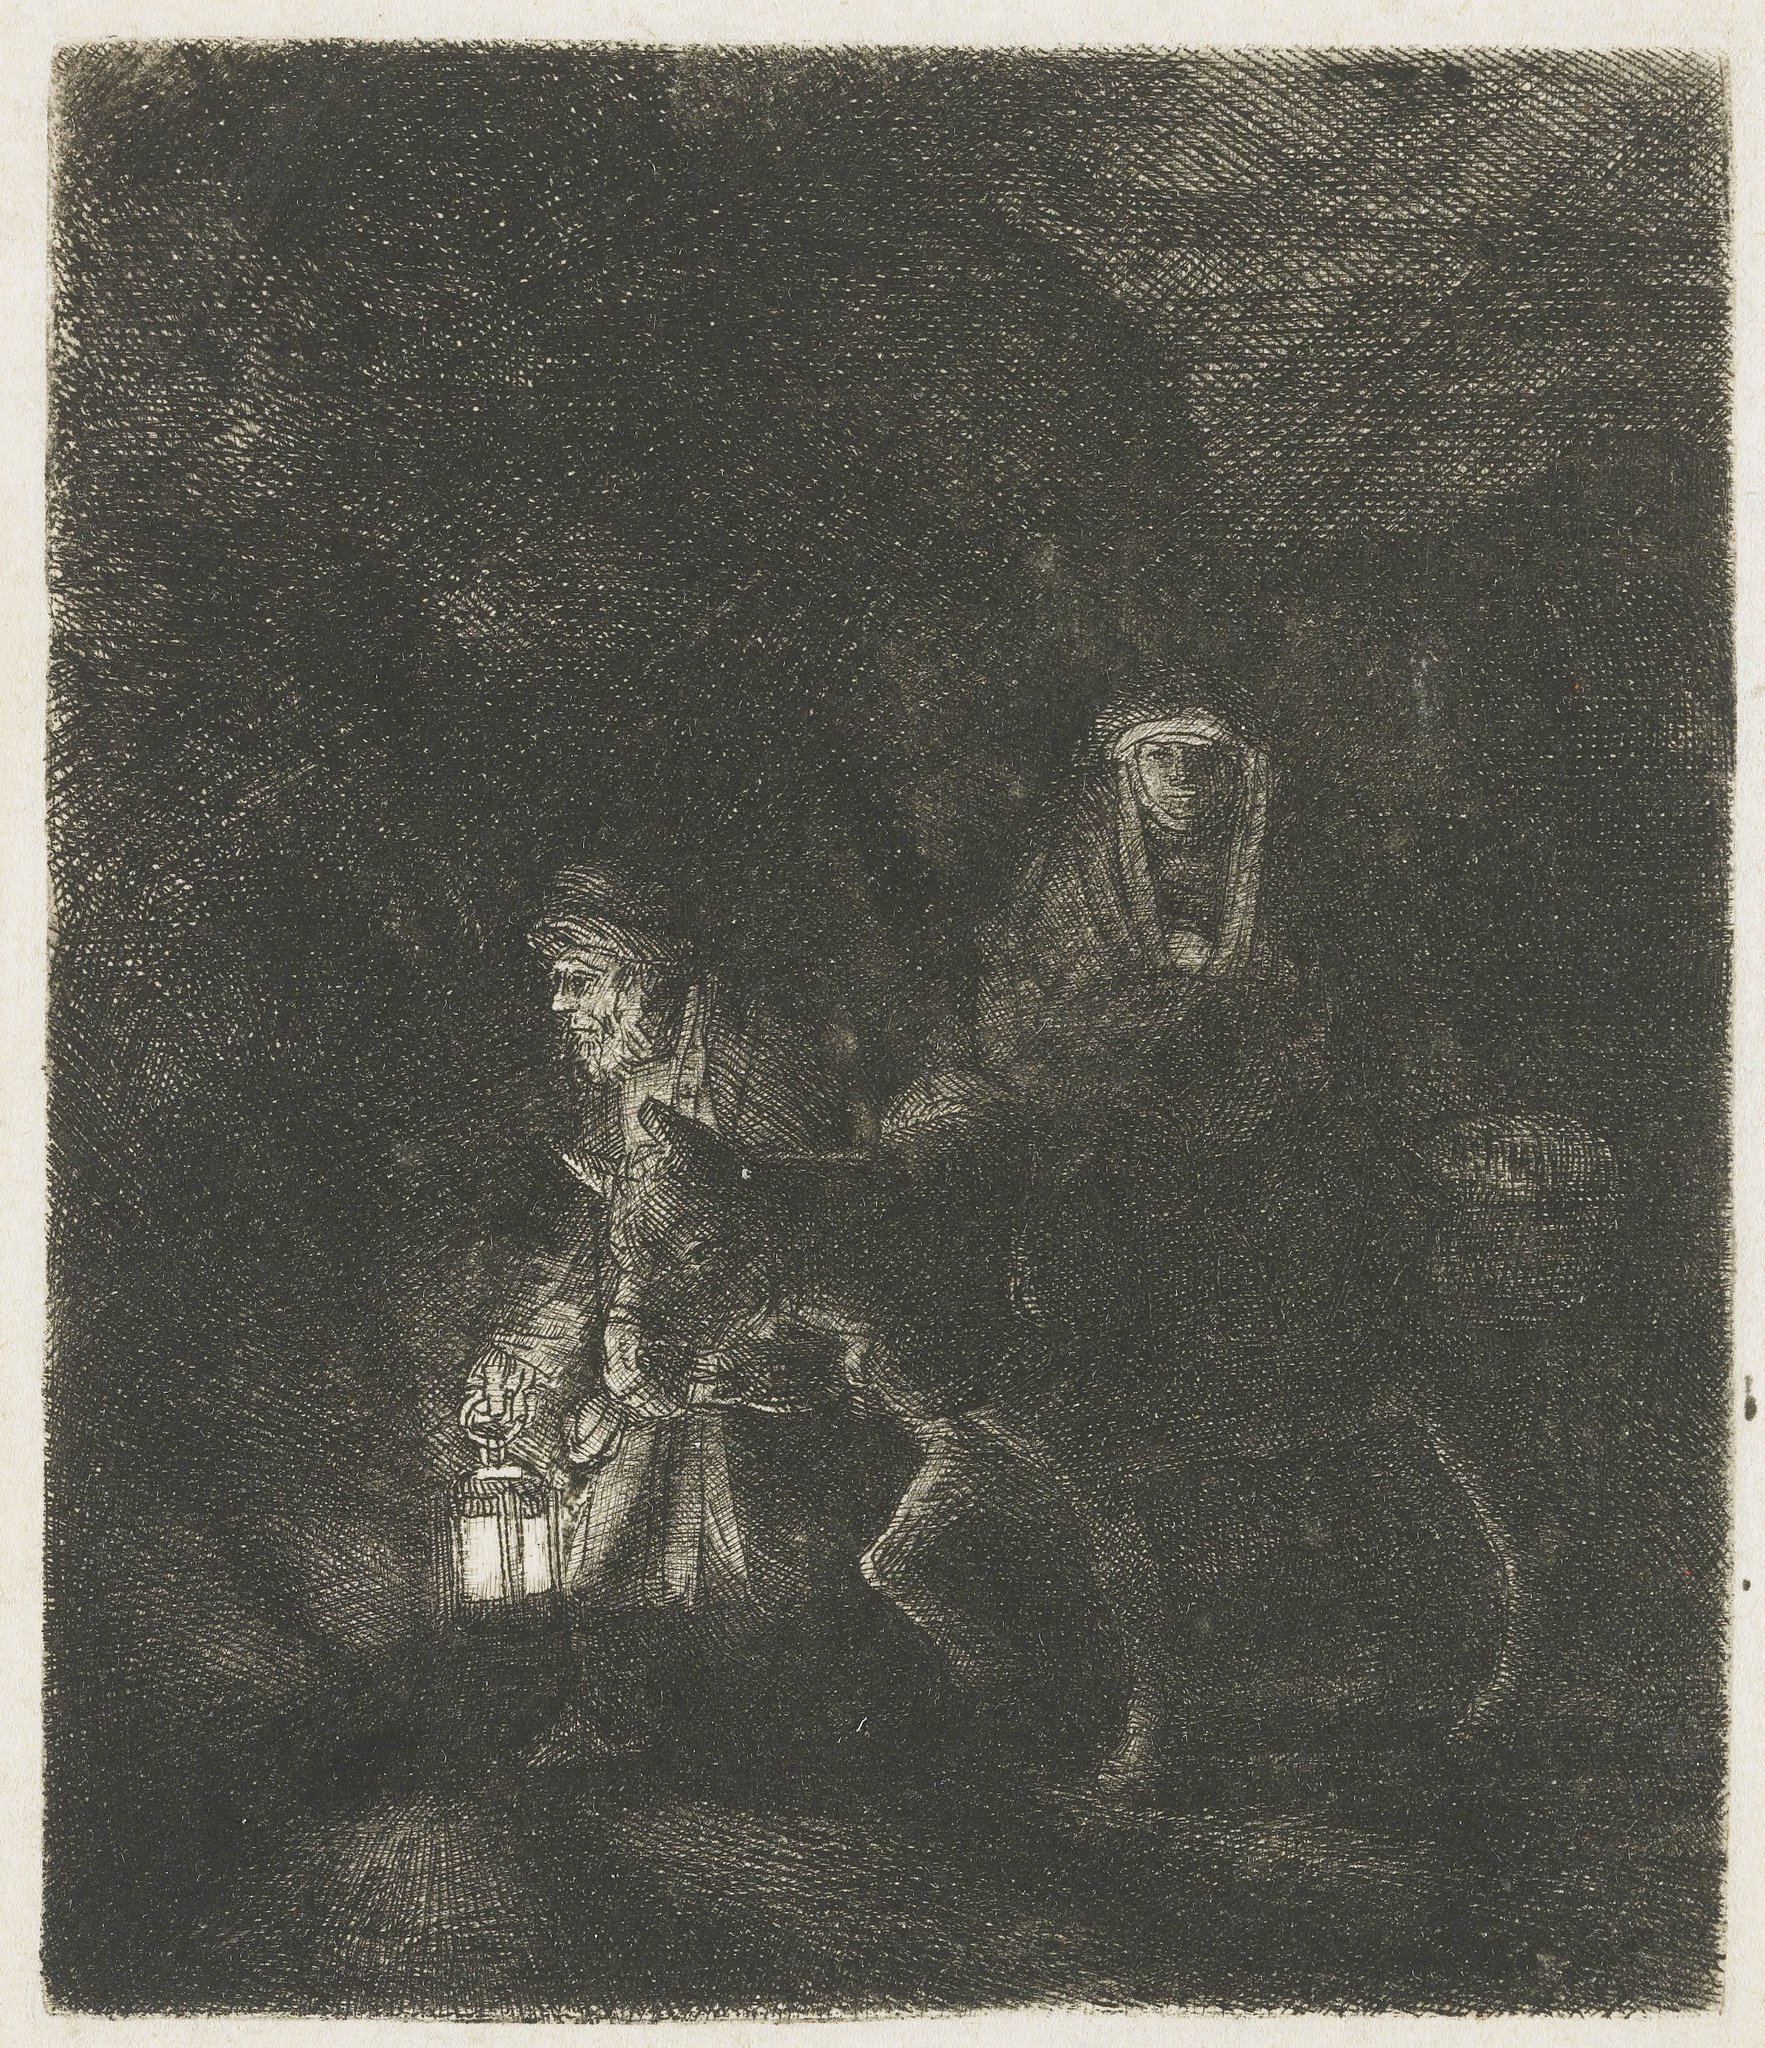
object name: print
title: The flight into Egypt: a night piece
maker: rembrandt van rijn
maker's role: draughtsman, painter, print maker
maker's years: 1606-1669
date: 1651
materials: paper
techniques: drypoint, etching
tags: the flight into egypt: mary, joseph, the child (and sometimes others) on their way; mary usually riding on an ass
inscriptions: collector's mark: Lugt 240, signature and date: ‘Rembrandt f. 1651’